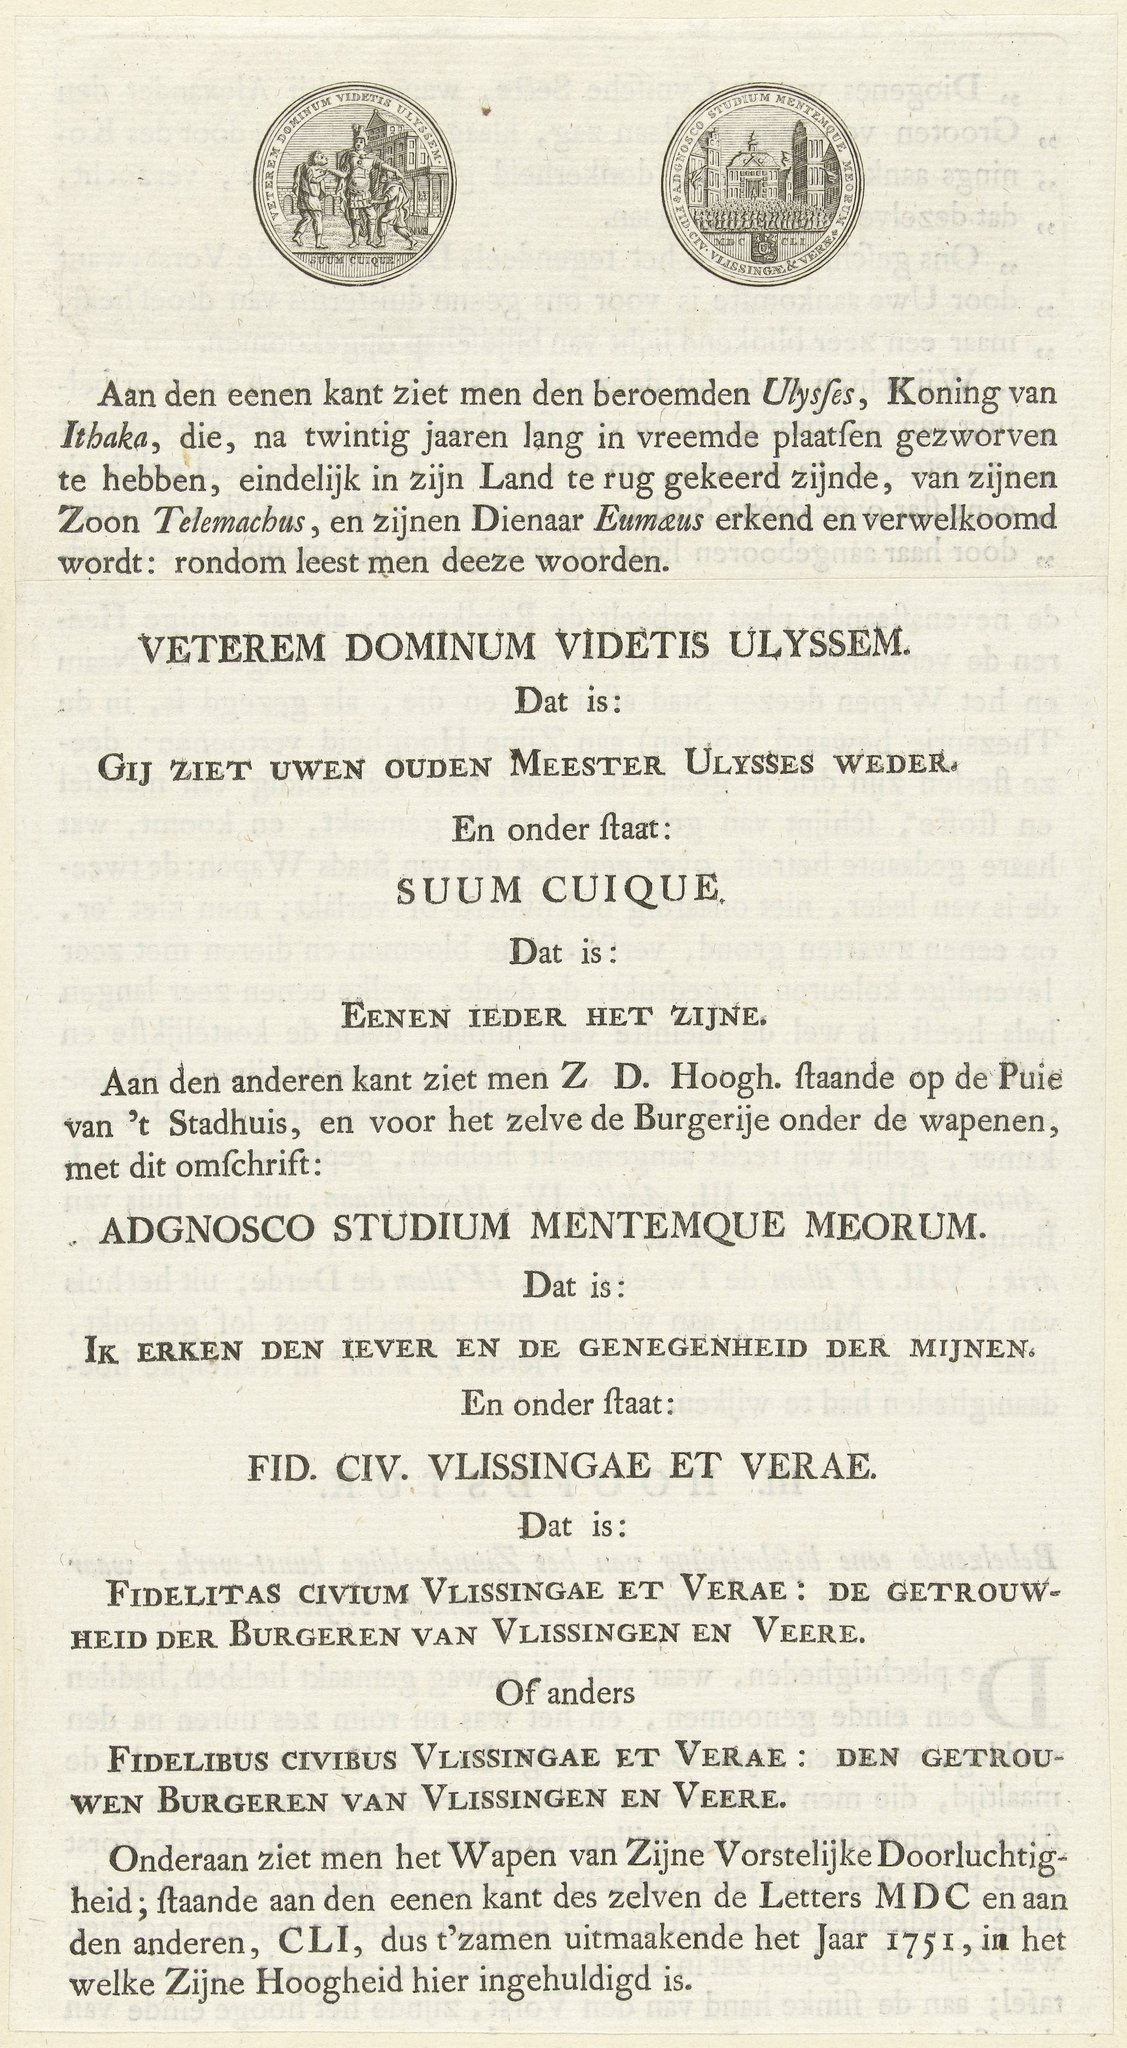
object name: penningverklaring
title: Pagina met de strooipenning ter gelegenheid van de inhuldiging van Willem IV, 1751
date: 1753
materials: paper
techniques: engraving, letterpress printing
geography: amsterdam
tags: the hague, willem iv (prins van oranje-nassau), medal (considered as a piece of sculpture, regardless of its specific function), flushing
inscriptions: collector's mark: Lugt 2228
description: Illustratie afkomstig uit: Daniel Théodore Huët, Inhuldiging van zijne doorluchtige hoogheid Willem Karel Hendrik Friso (...) als erf-heer van Vlissingen, op den Vden junij MDCCLI. Amsterdam: Isaak Tirion, 1753. Voor de penning zie de exemplaren in de collectie van het Rijksmuseum met de objectnummers: NG-VG-1-2554 en NG-VG-1-2555.